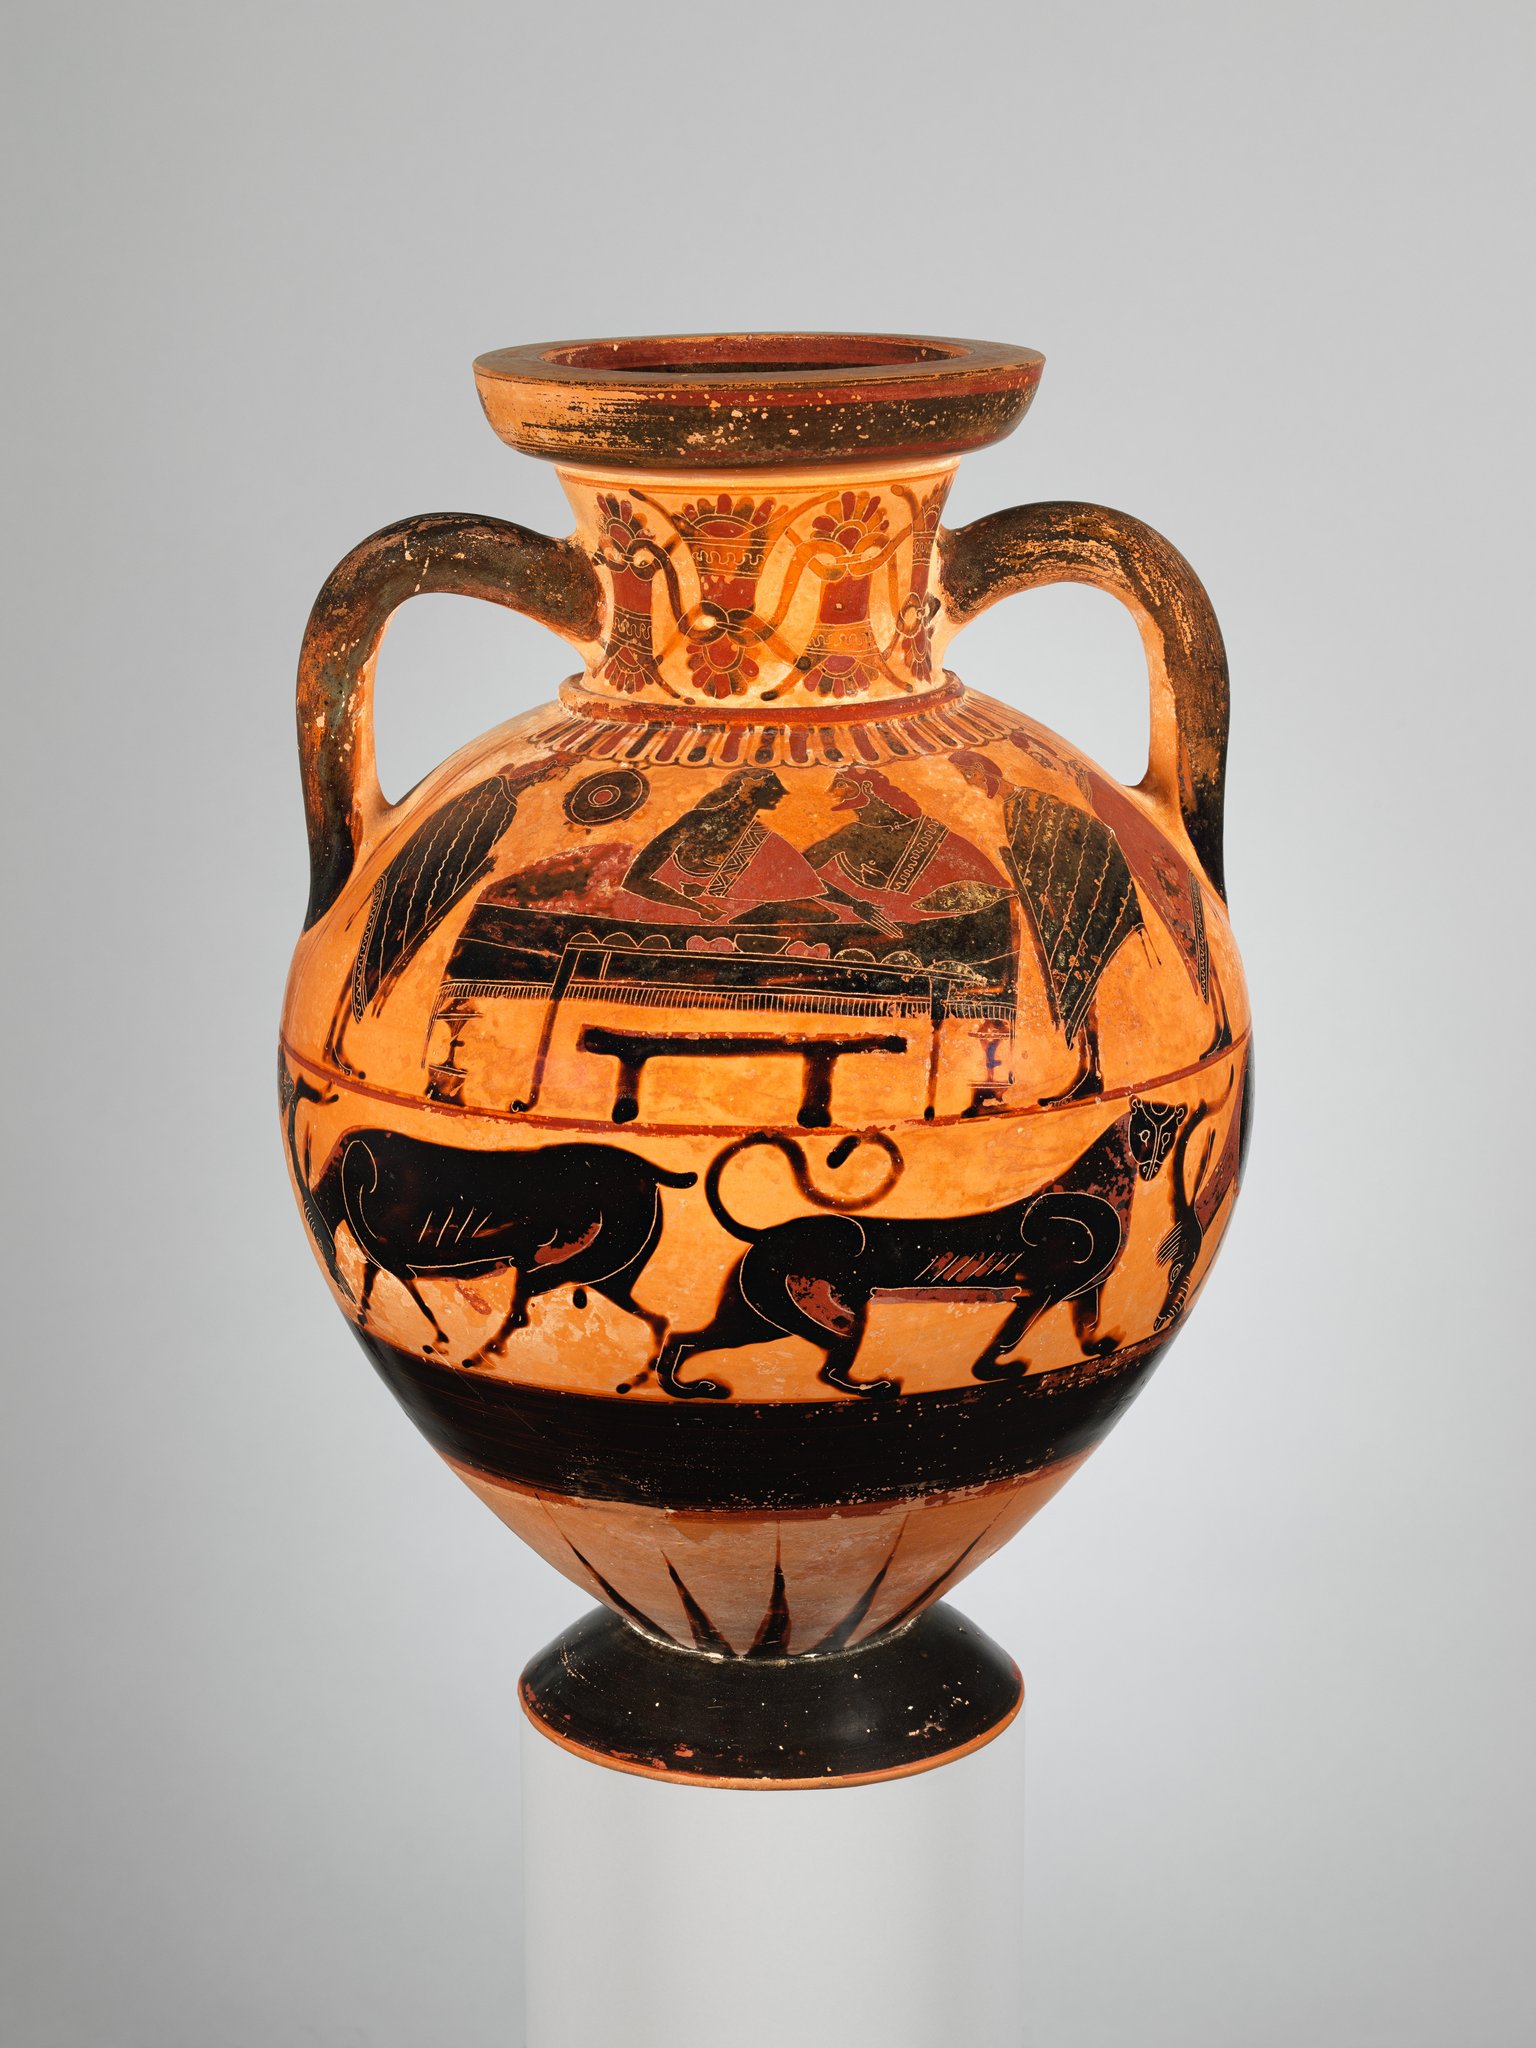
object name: neck amphora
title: Terracotta neck-amphora (jar)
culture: greek, attic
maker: ptoon painter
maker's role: artist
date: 570-560 BCE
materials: terracotta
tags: dionysus,ariadne,goats,panthers,banquets